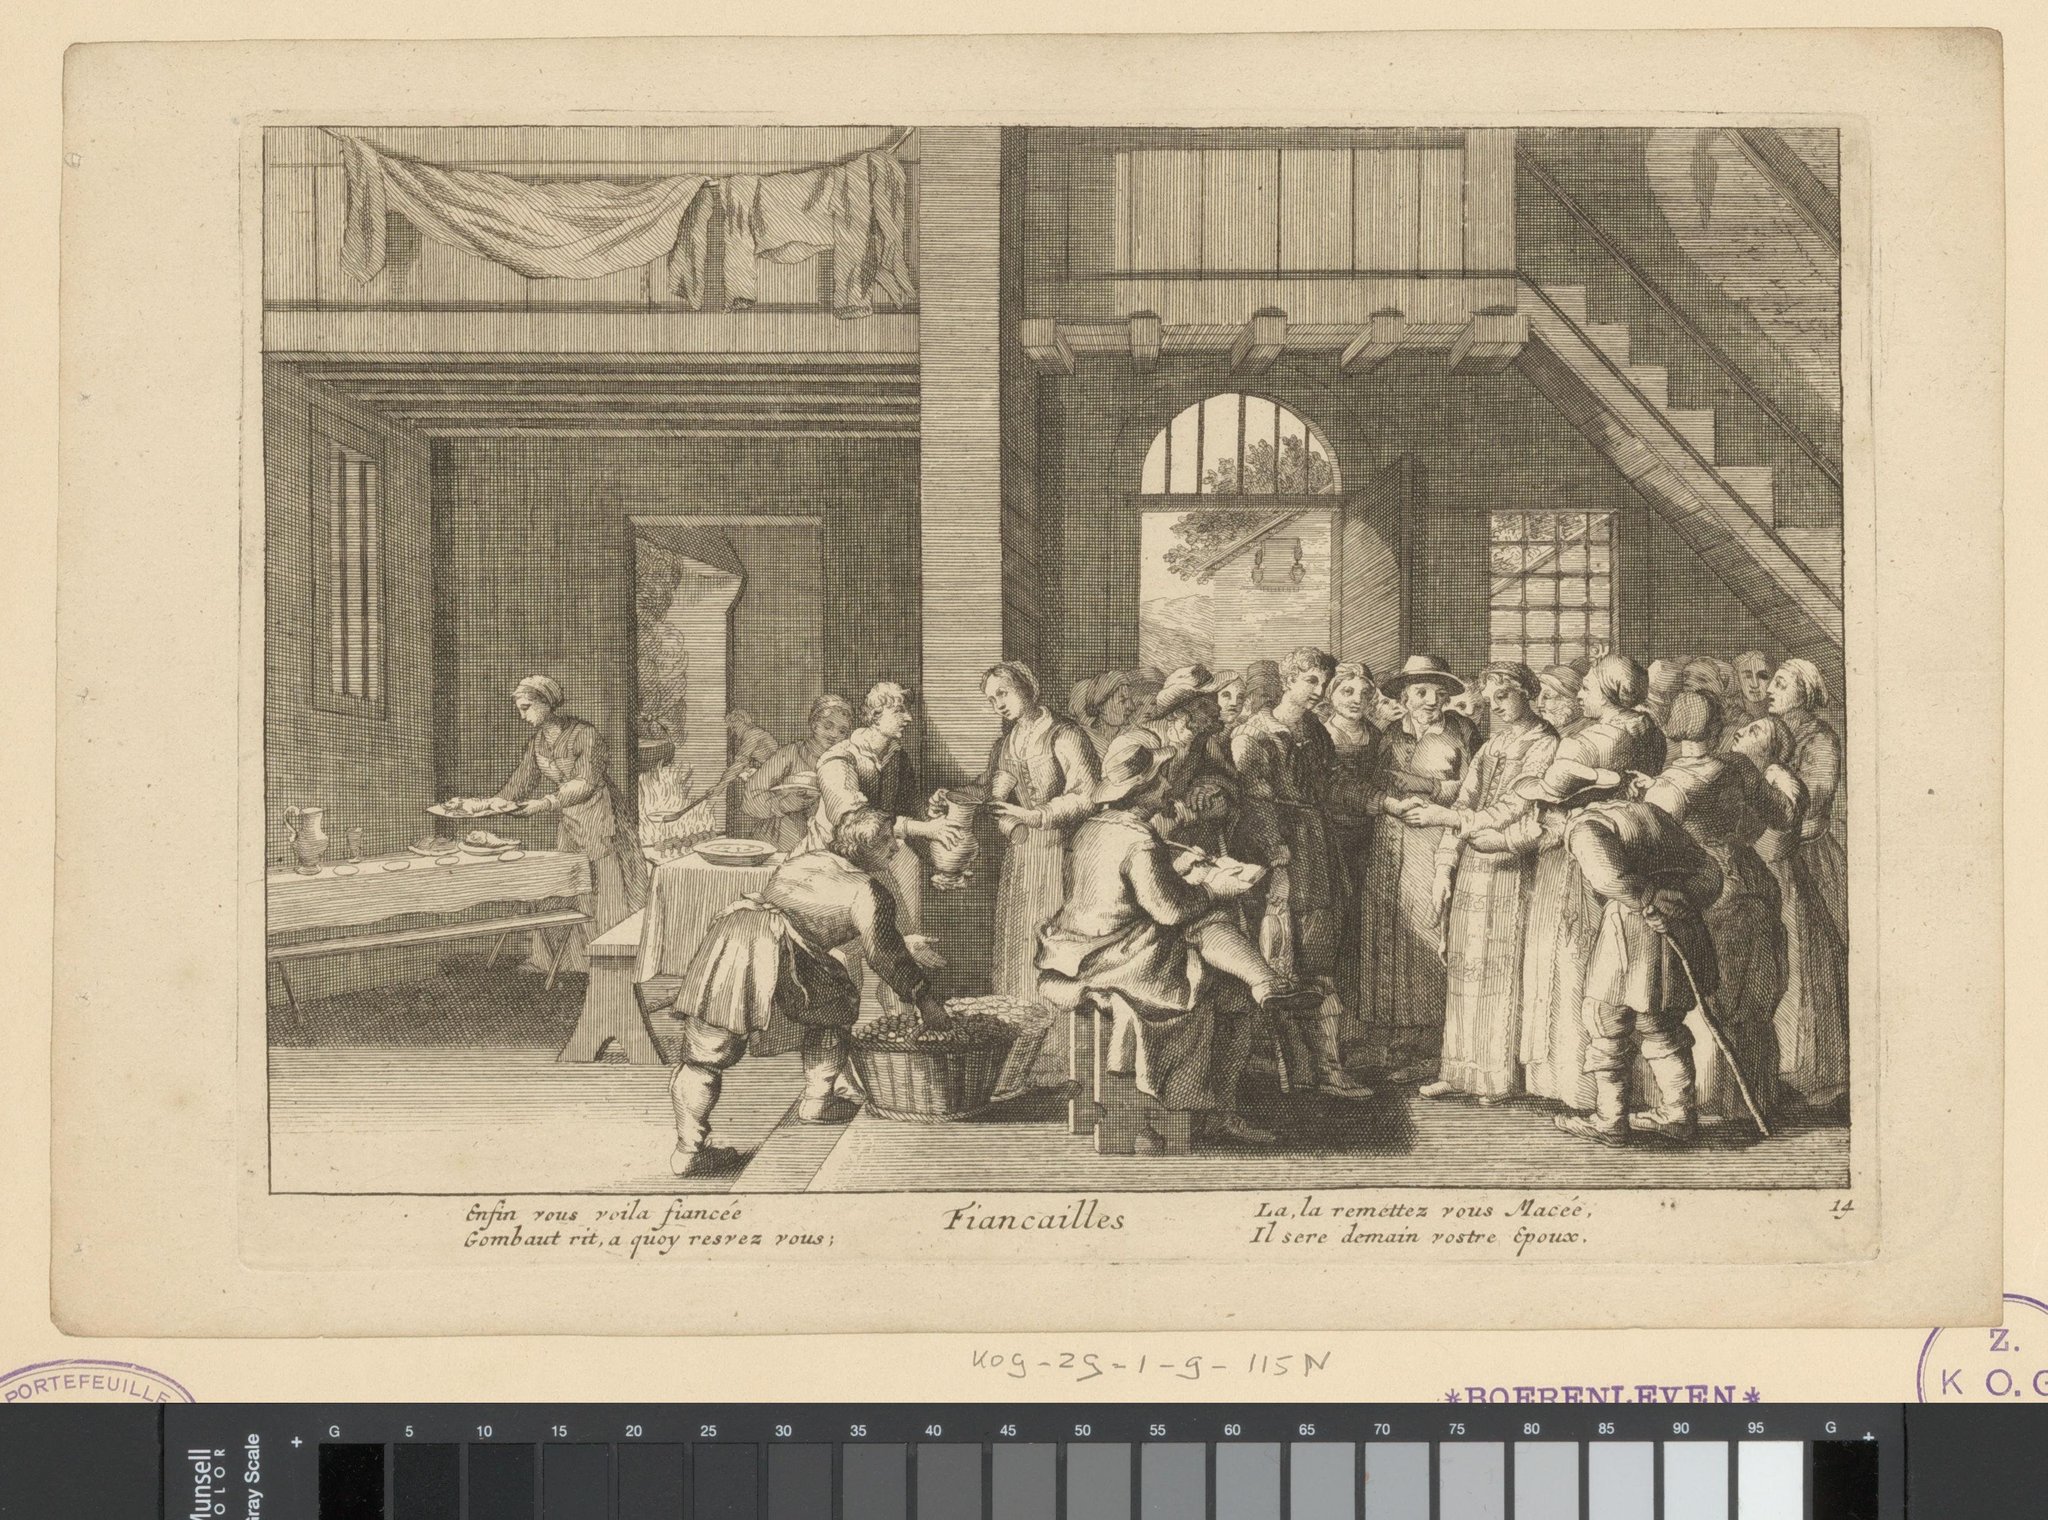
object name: print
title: Fiancailles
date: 1670-1726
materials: paper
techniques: engraving, etching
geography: amsterdam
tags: evening meal, dinner, supper, betrothal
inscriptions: stamp:, collector's mark: Lugt 1641, stamp:, collector's mark: Lugt 1641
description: Onderaan genummerd: 14. Onderwerpsrubrieken binnen de Atlas Zeden en Gewoonten: Handel, nijverheid en verkeer, Boerenleven.